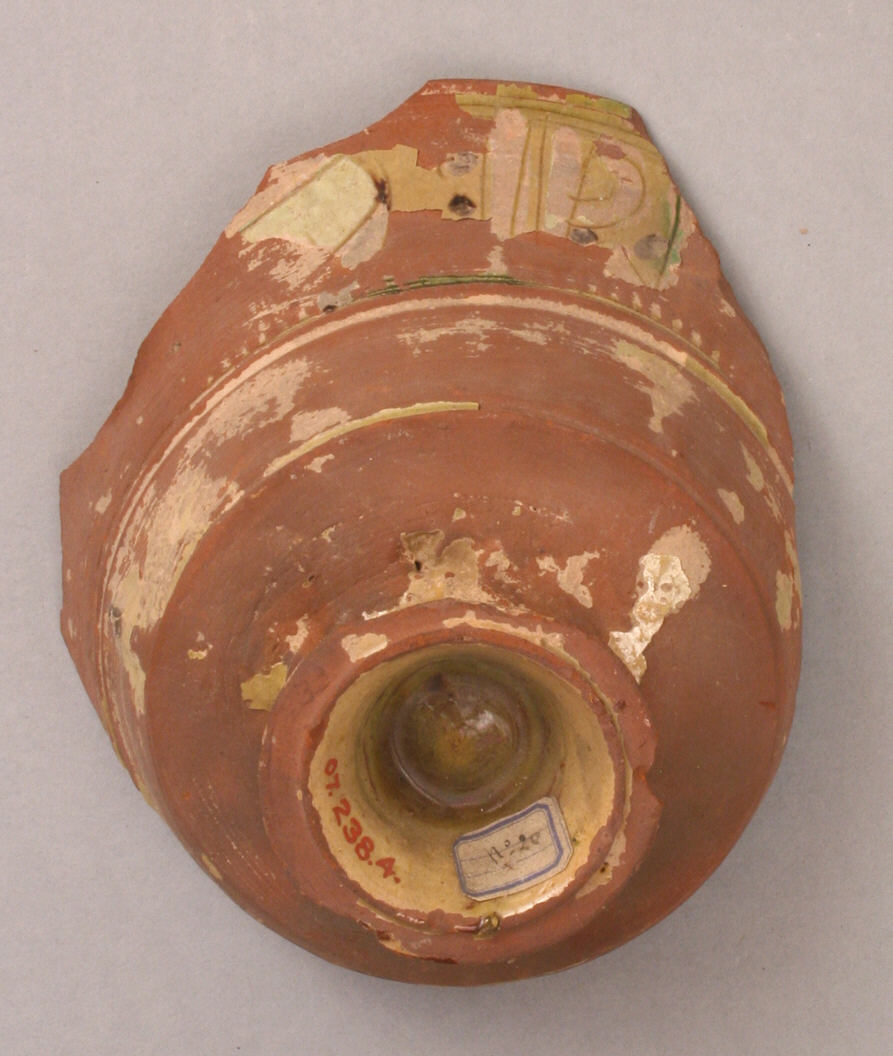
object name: fragment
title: Fragment of a Bowl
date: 1301-1500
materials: earthenware, glaze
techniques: coloring, incising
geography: egypt